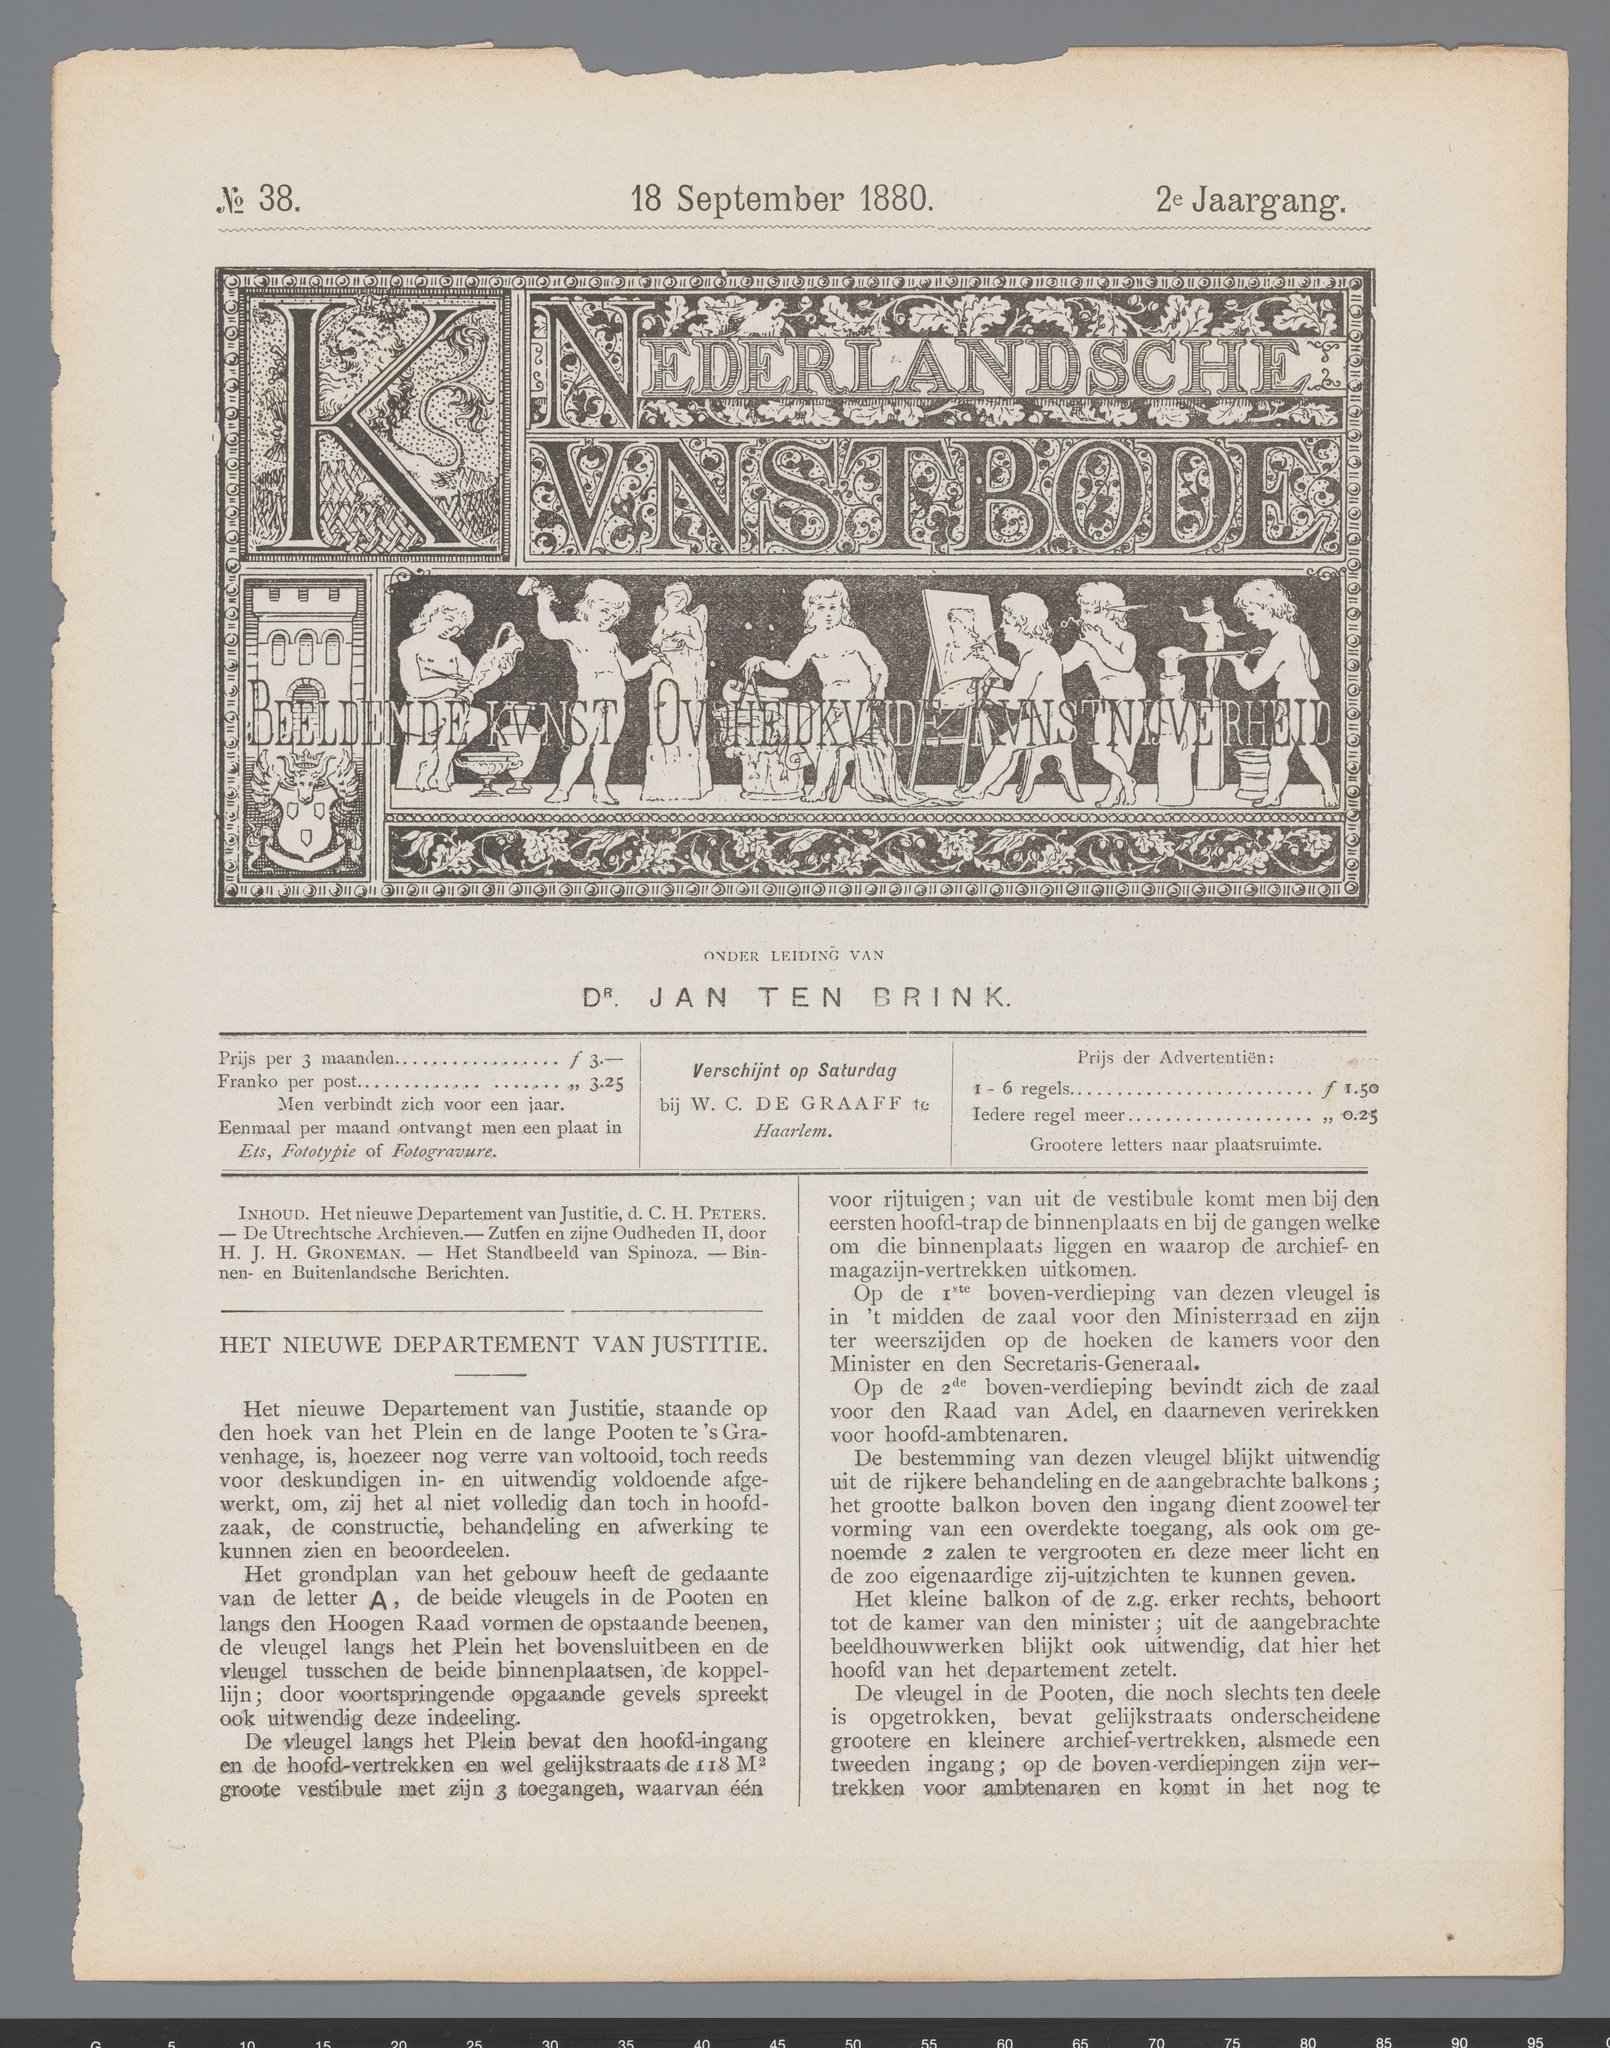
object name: print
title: Nederlandsche Kunstbode, Beeldende kunst, Oudheidkunde, Kunstnijverheid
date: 1880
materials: paper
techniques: letterpress printing, lithograph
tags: art, craftsman ~ applied arts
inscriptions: date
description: Prent uit: Nederlandsche Kunstbode, 2 (1880).